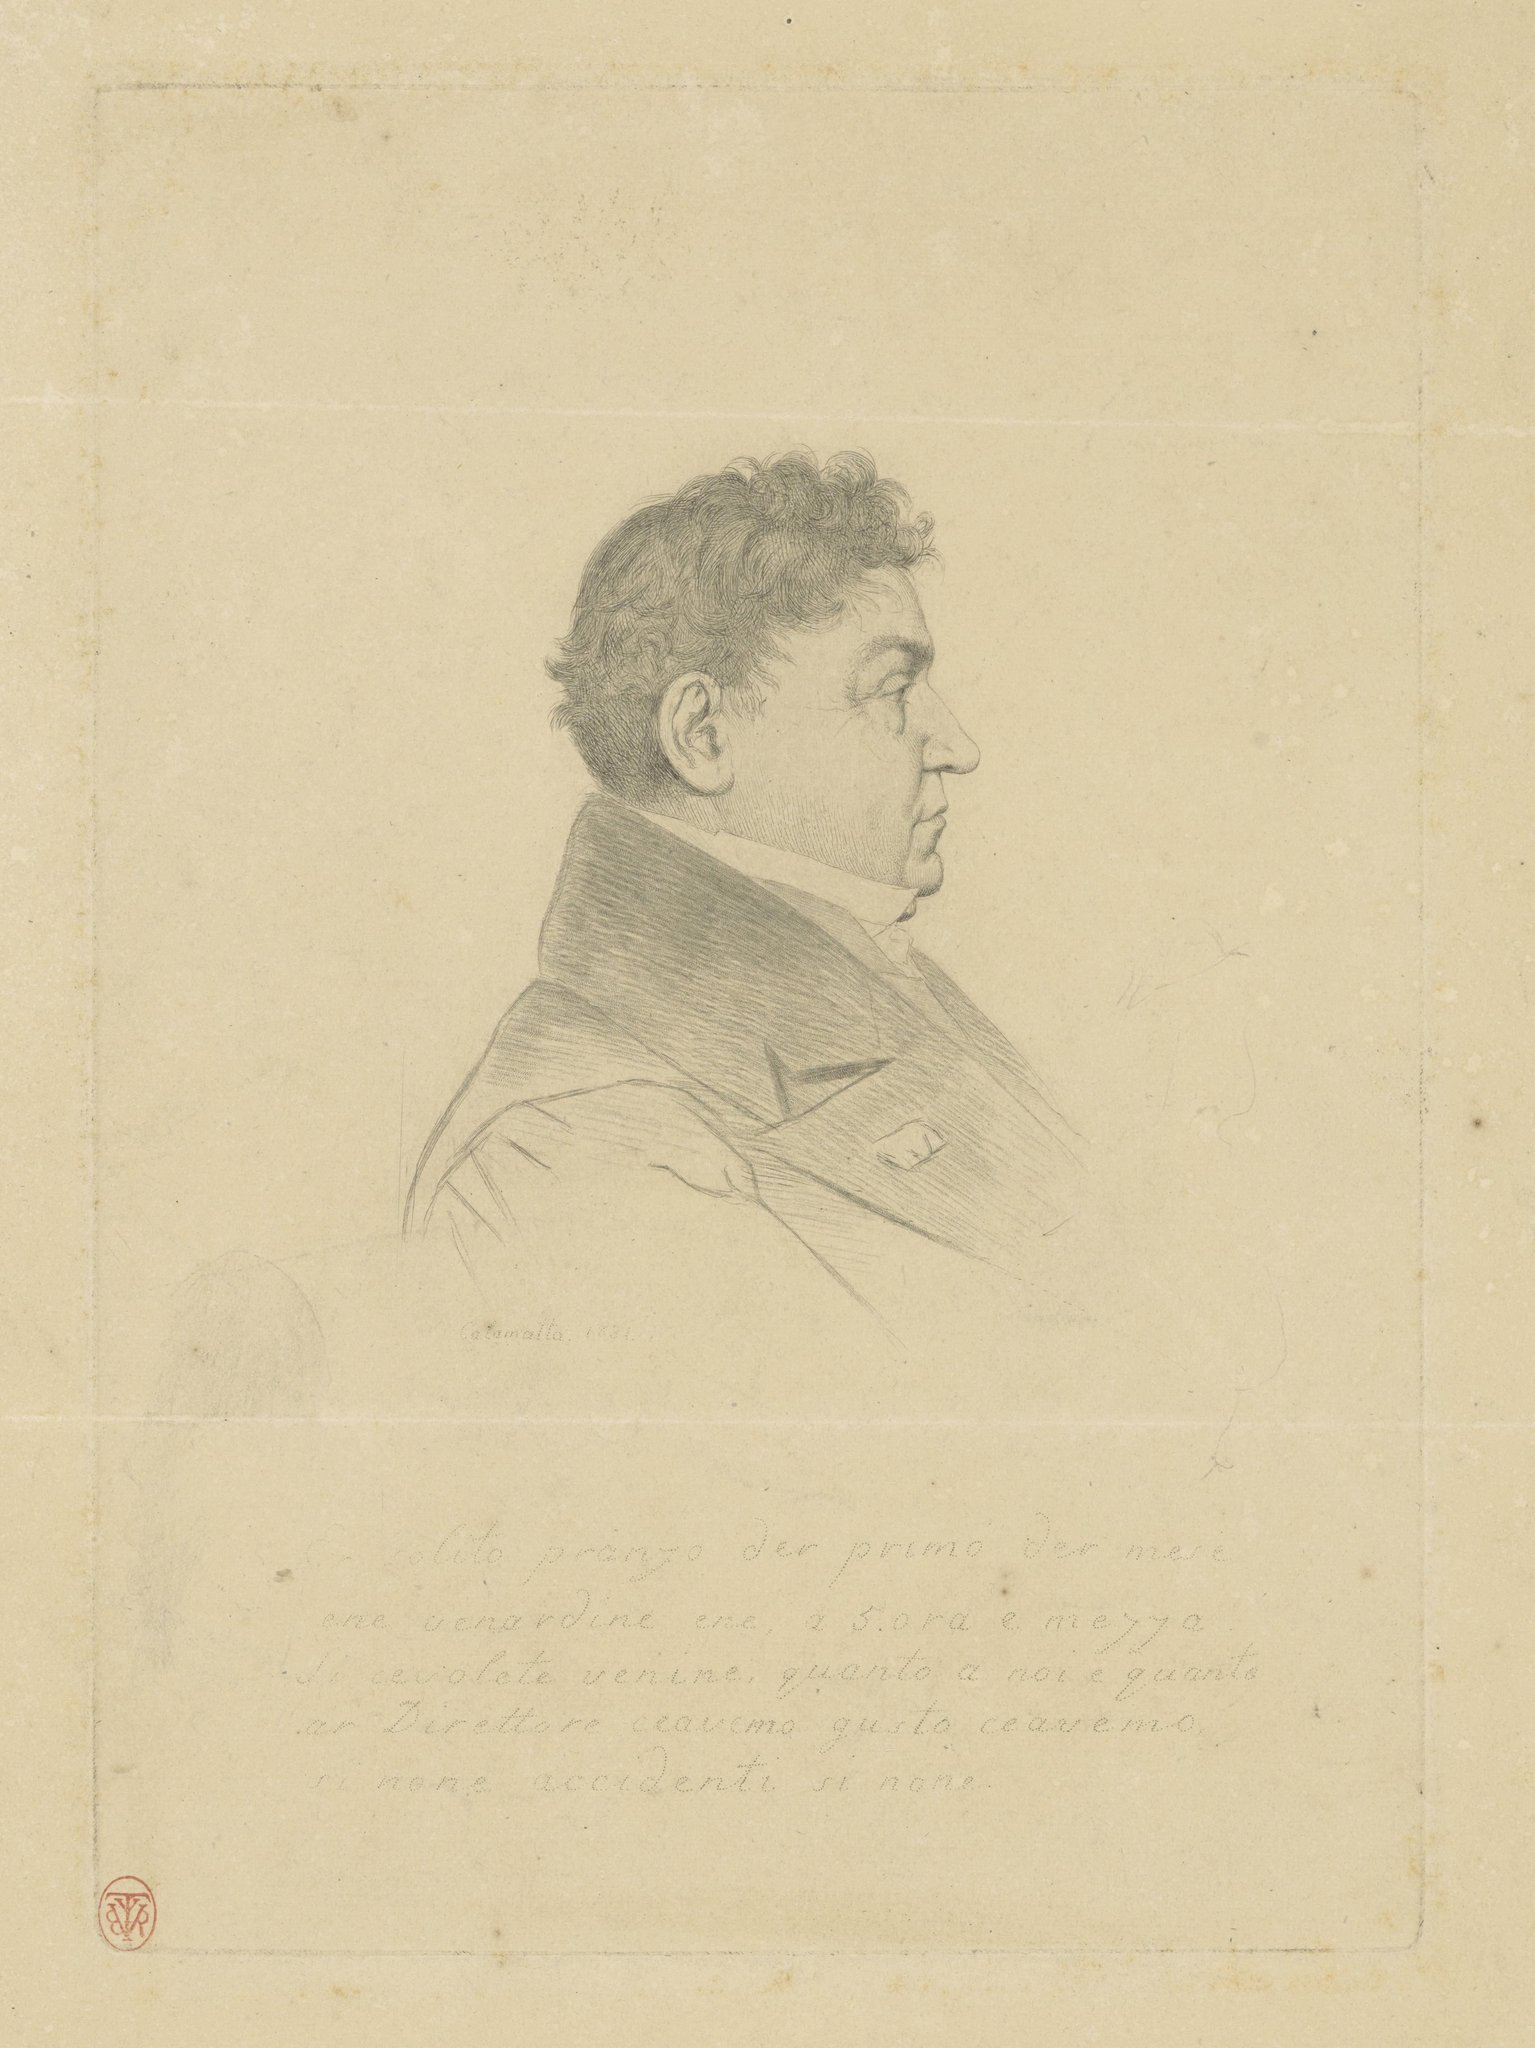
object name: print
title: Portret van een man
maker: luigi calamatta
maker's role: print maker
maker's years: 1801-1869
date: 1831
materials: paper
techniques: etching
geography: italy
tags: anonymous historical person portrayed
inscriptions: collector's mark: Lugt 413, collector's mark: Lugt 2233